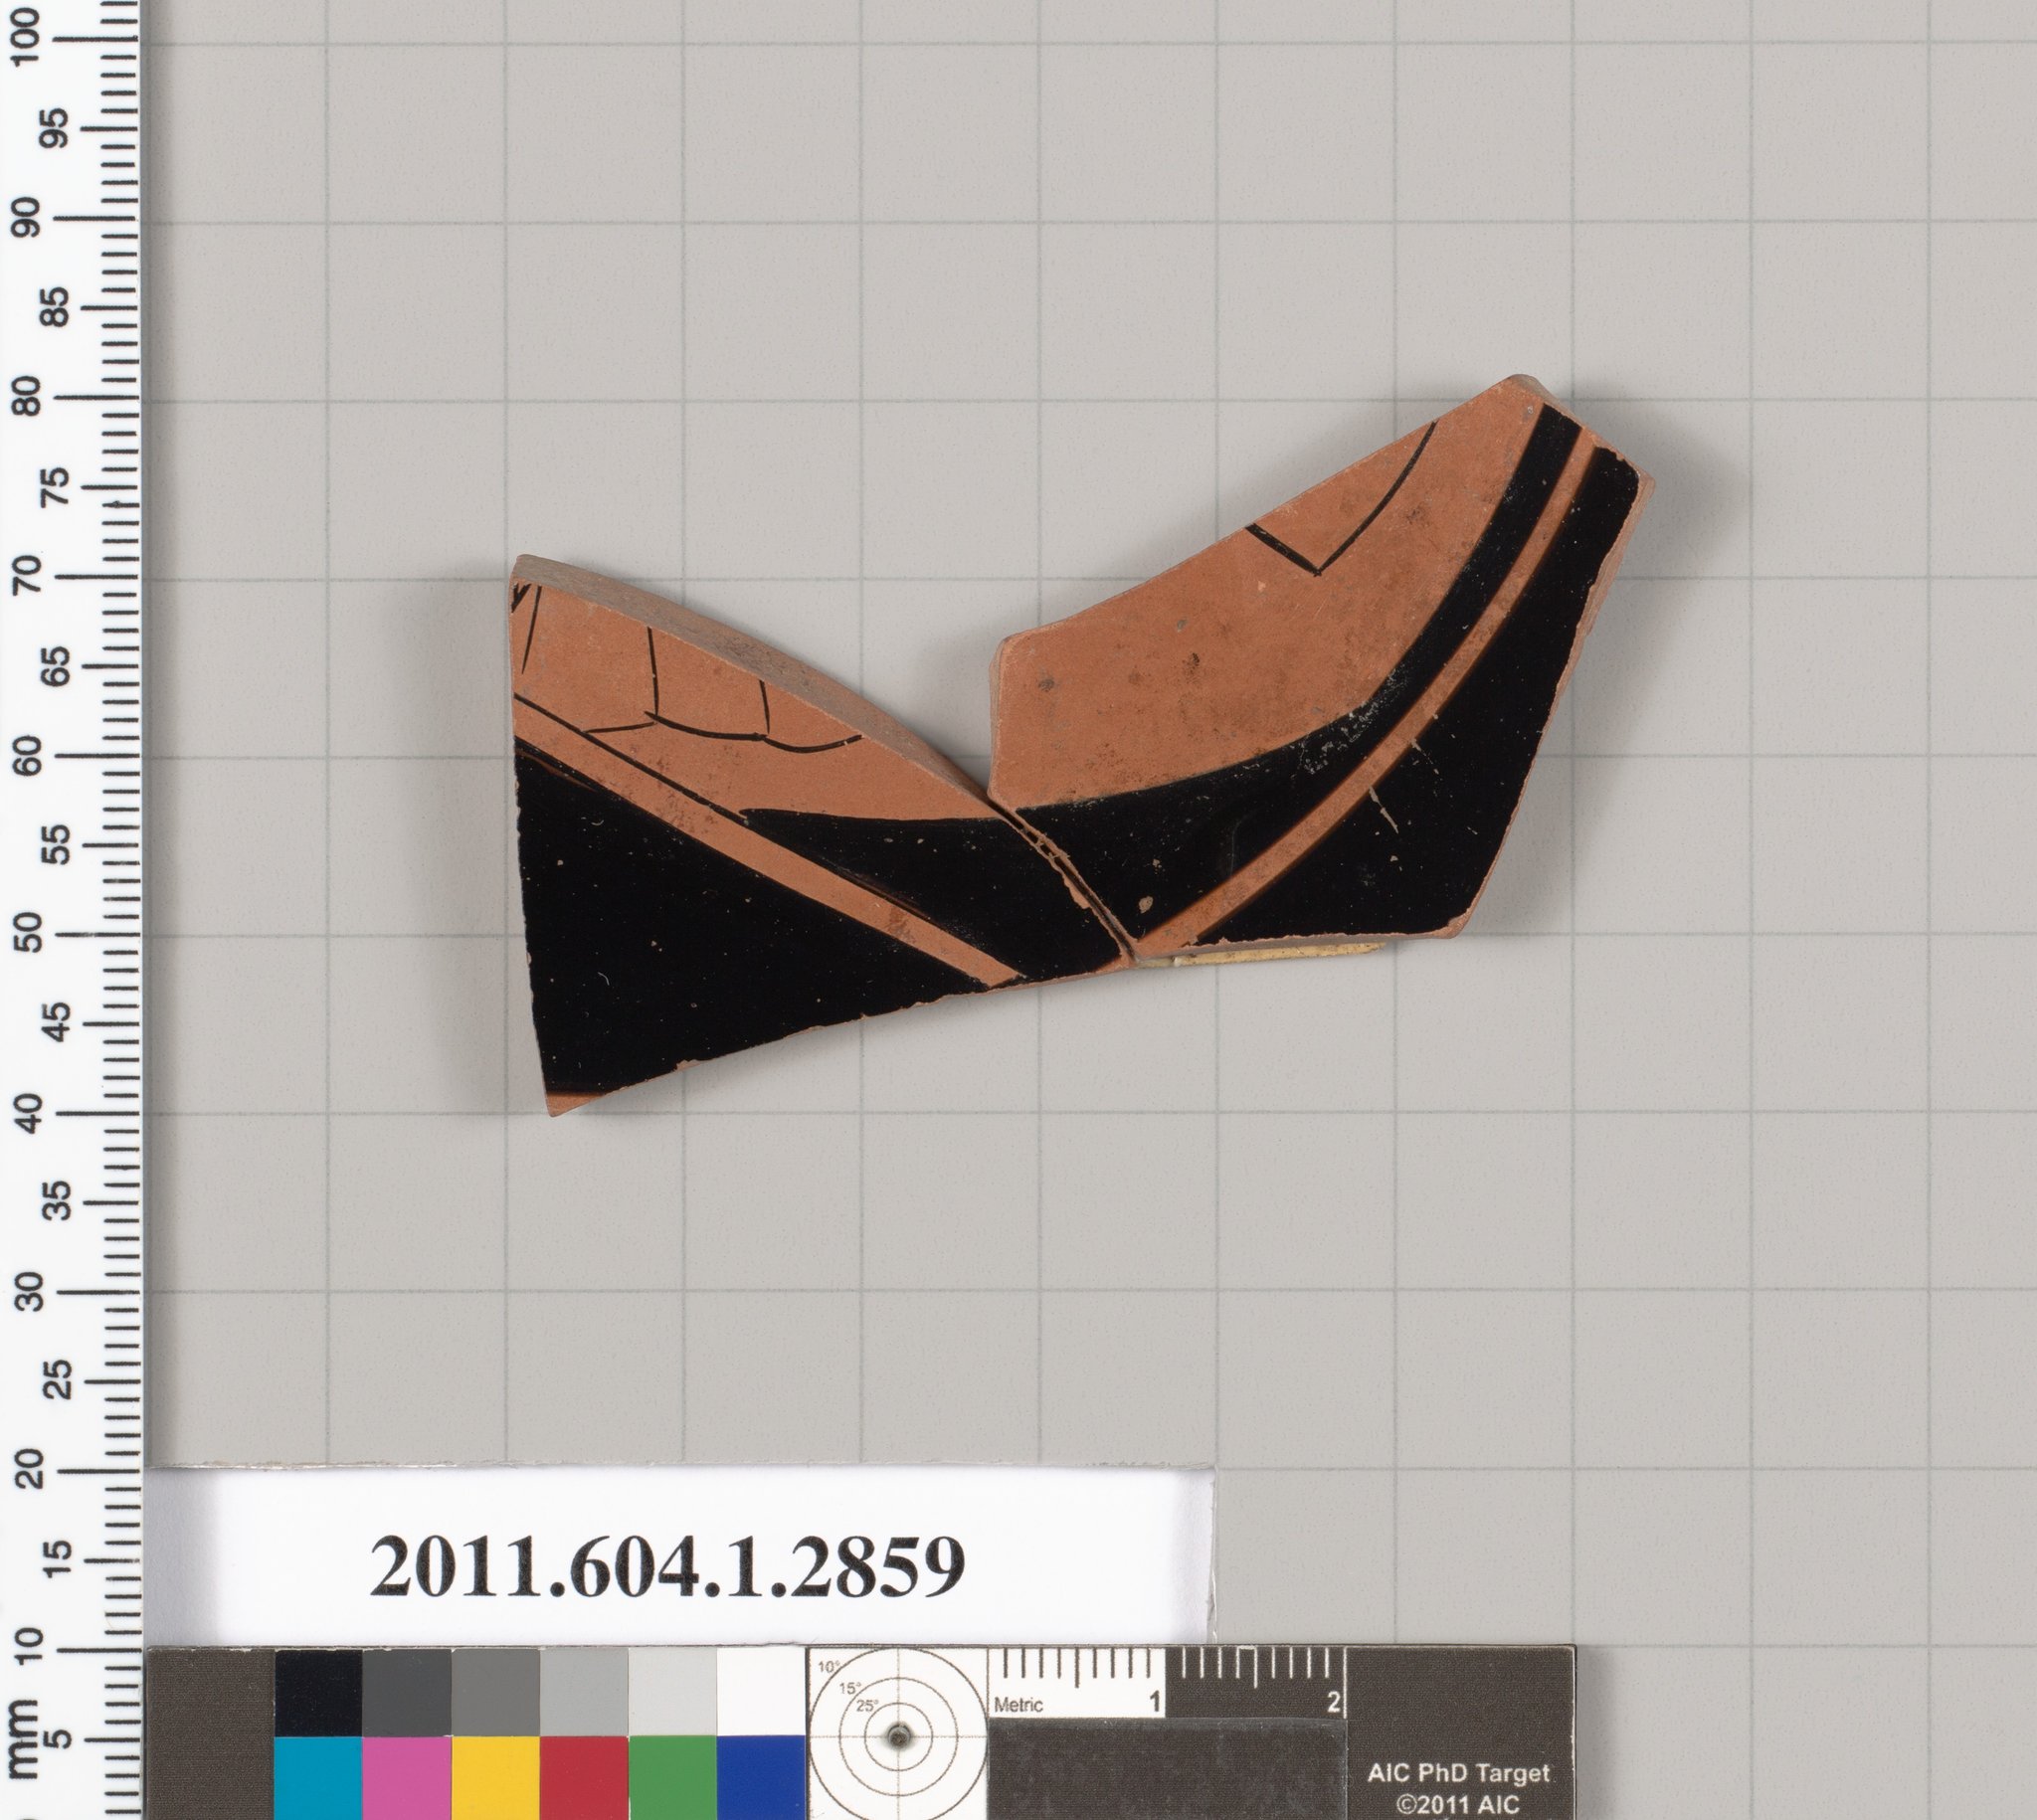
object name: kylix fragment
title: Terracotta fragment of a kylix (drinking cup)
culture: greek, attic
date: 500-476 BCE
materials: terracotta